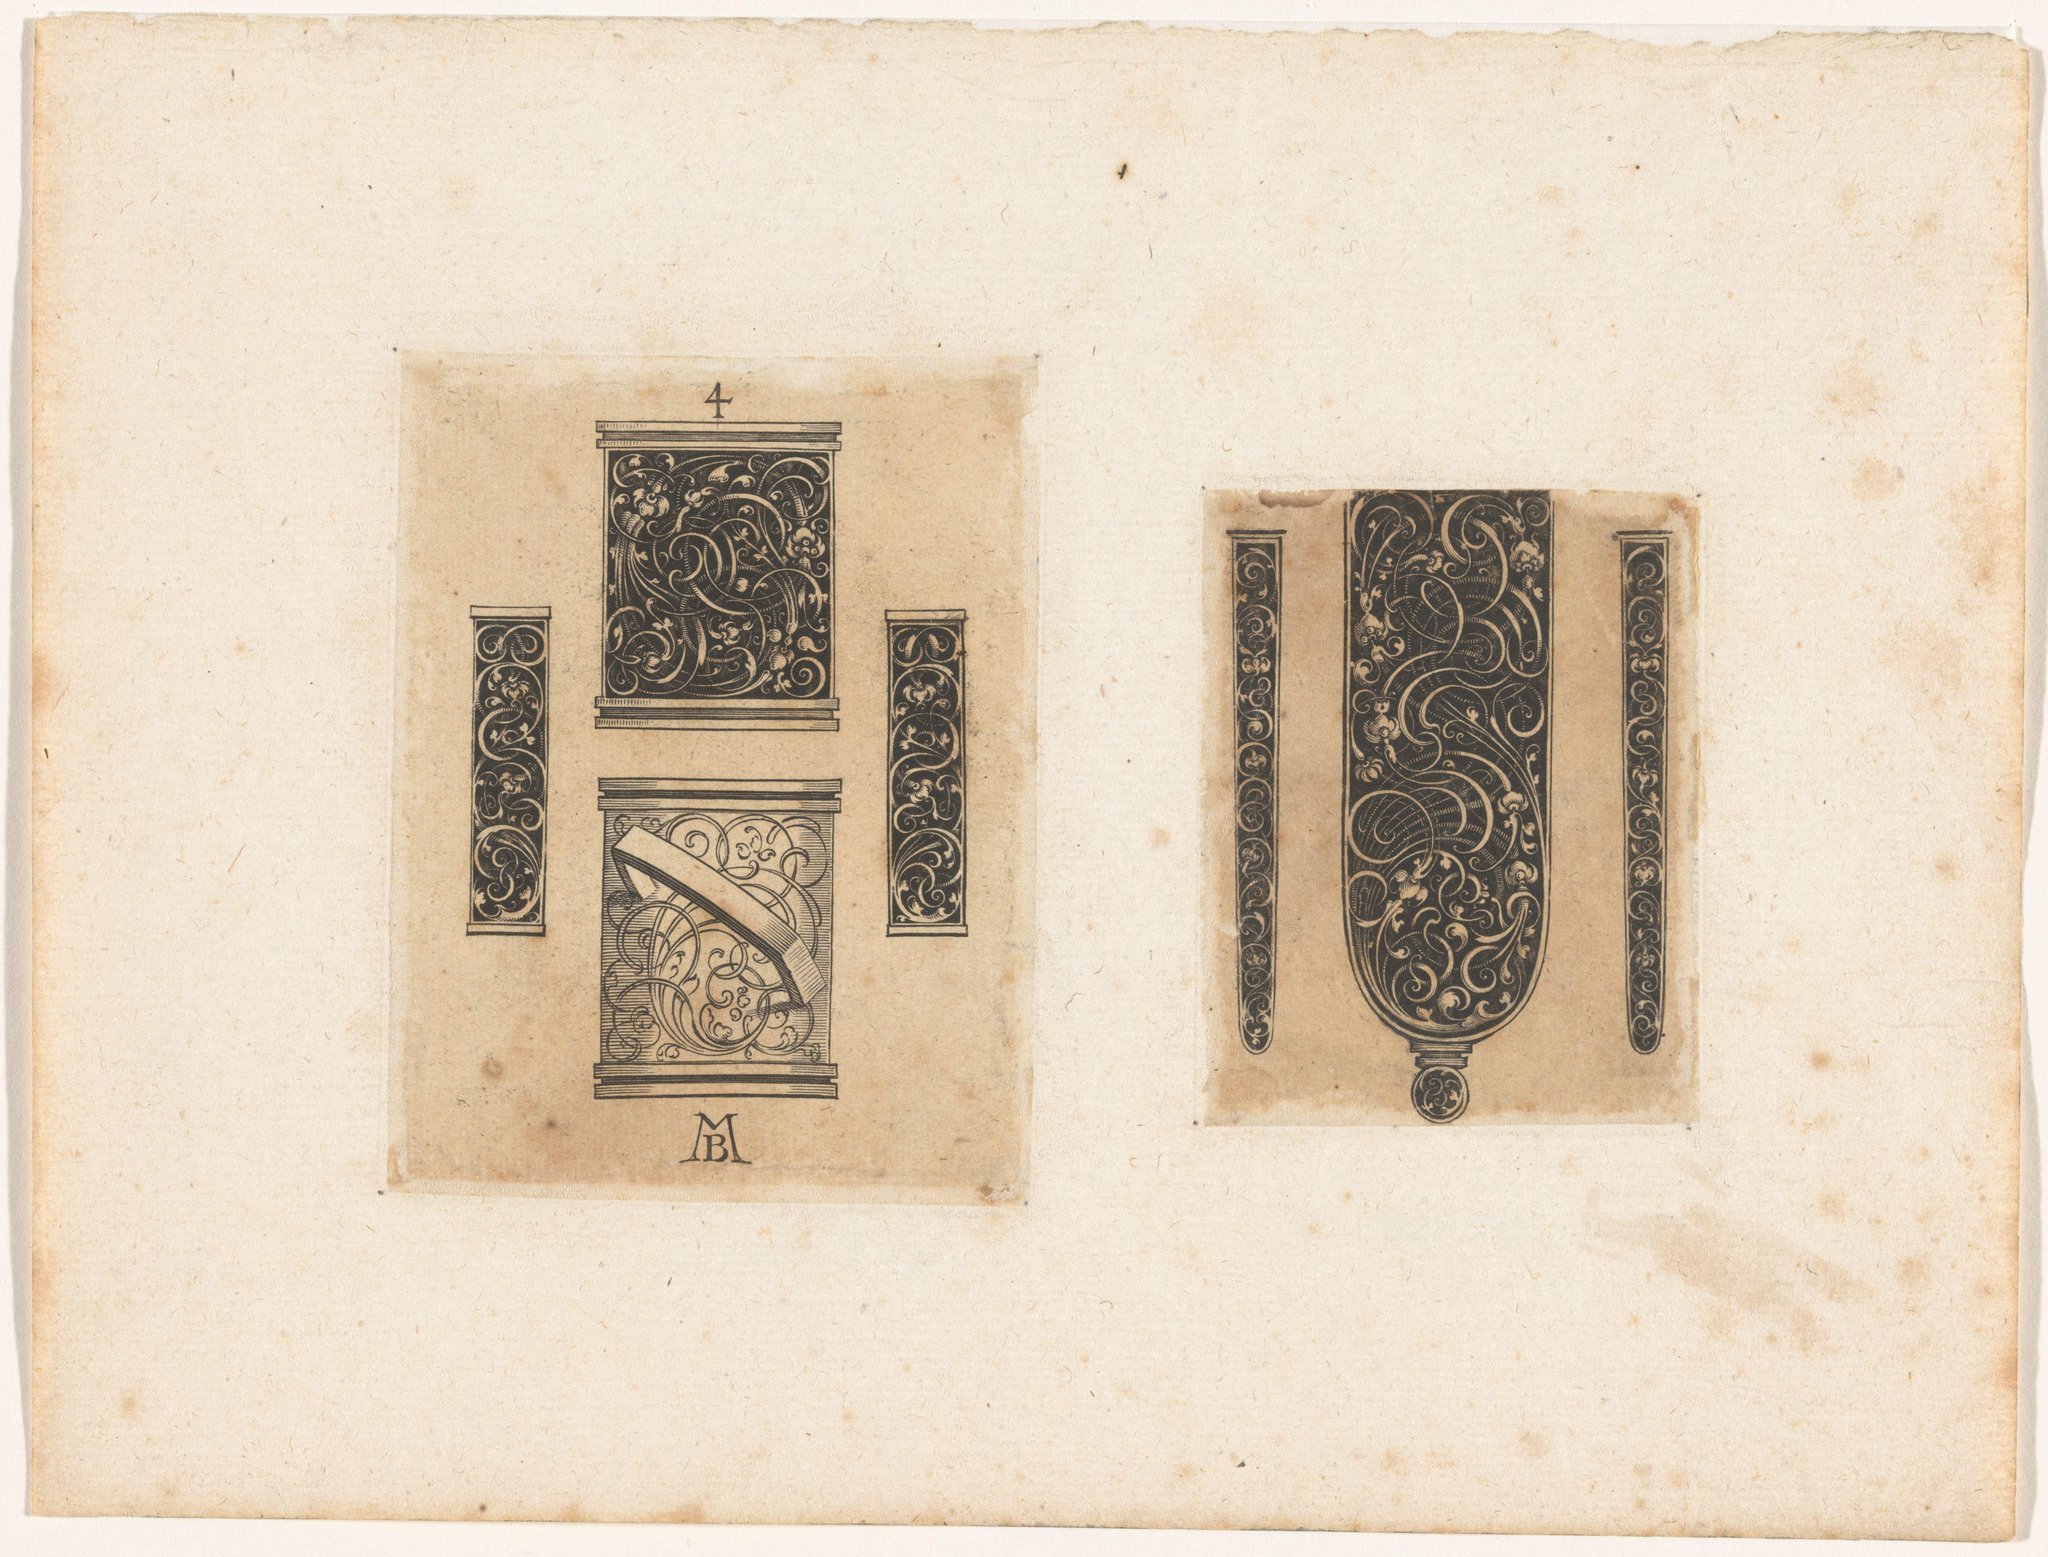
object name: print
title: Delen van degenscheden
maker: michiel le blon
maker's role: print maker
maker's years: 1587-1656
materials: paper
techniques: etching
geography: amsterdam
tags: ornaments ~ art, foliage ~ ornament, hacking and thrusting weapons: sword (+ variant), ornament derived from plant forms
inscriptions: collector's mark: Lugt 2760, monogram: ‘MB (M boven B)’, collector's mark: Lugt 2228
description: Twee decoratieve randen voor mondblikken boven elkaar en twee kleine vlakdecoraties met gebladerde ranken.